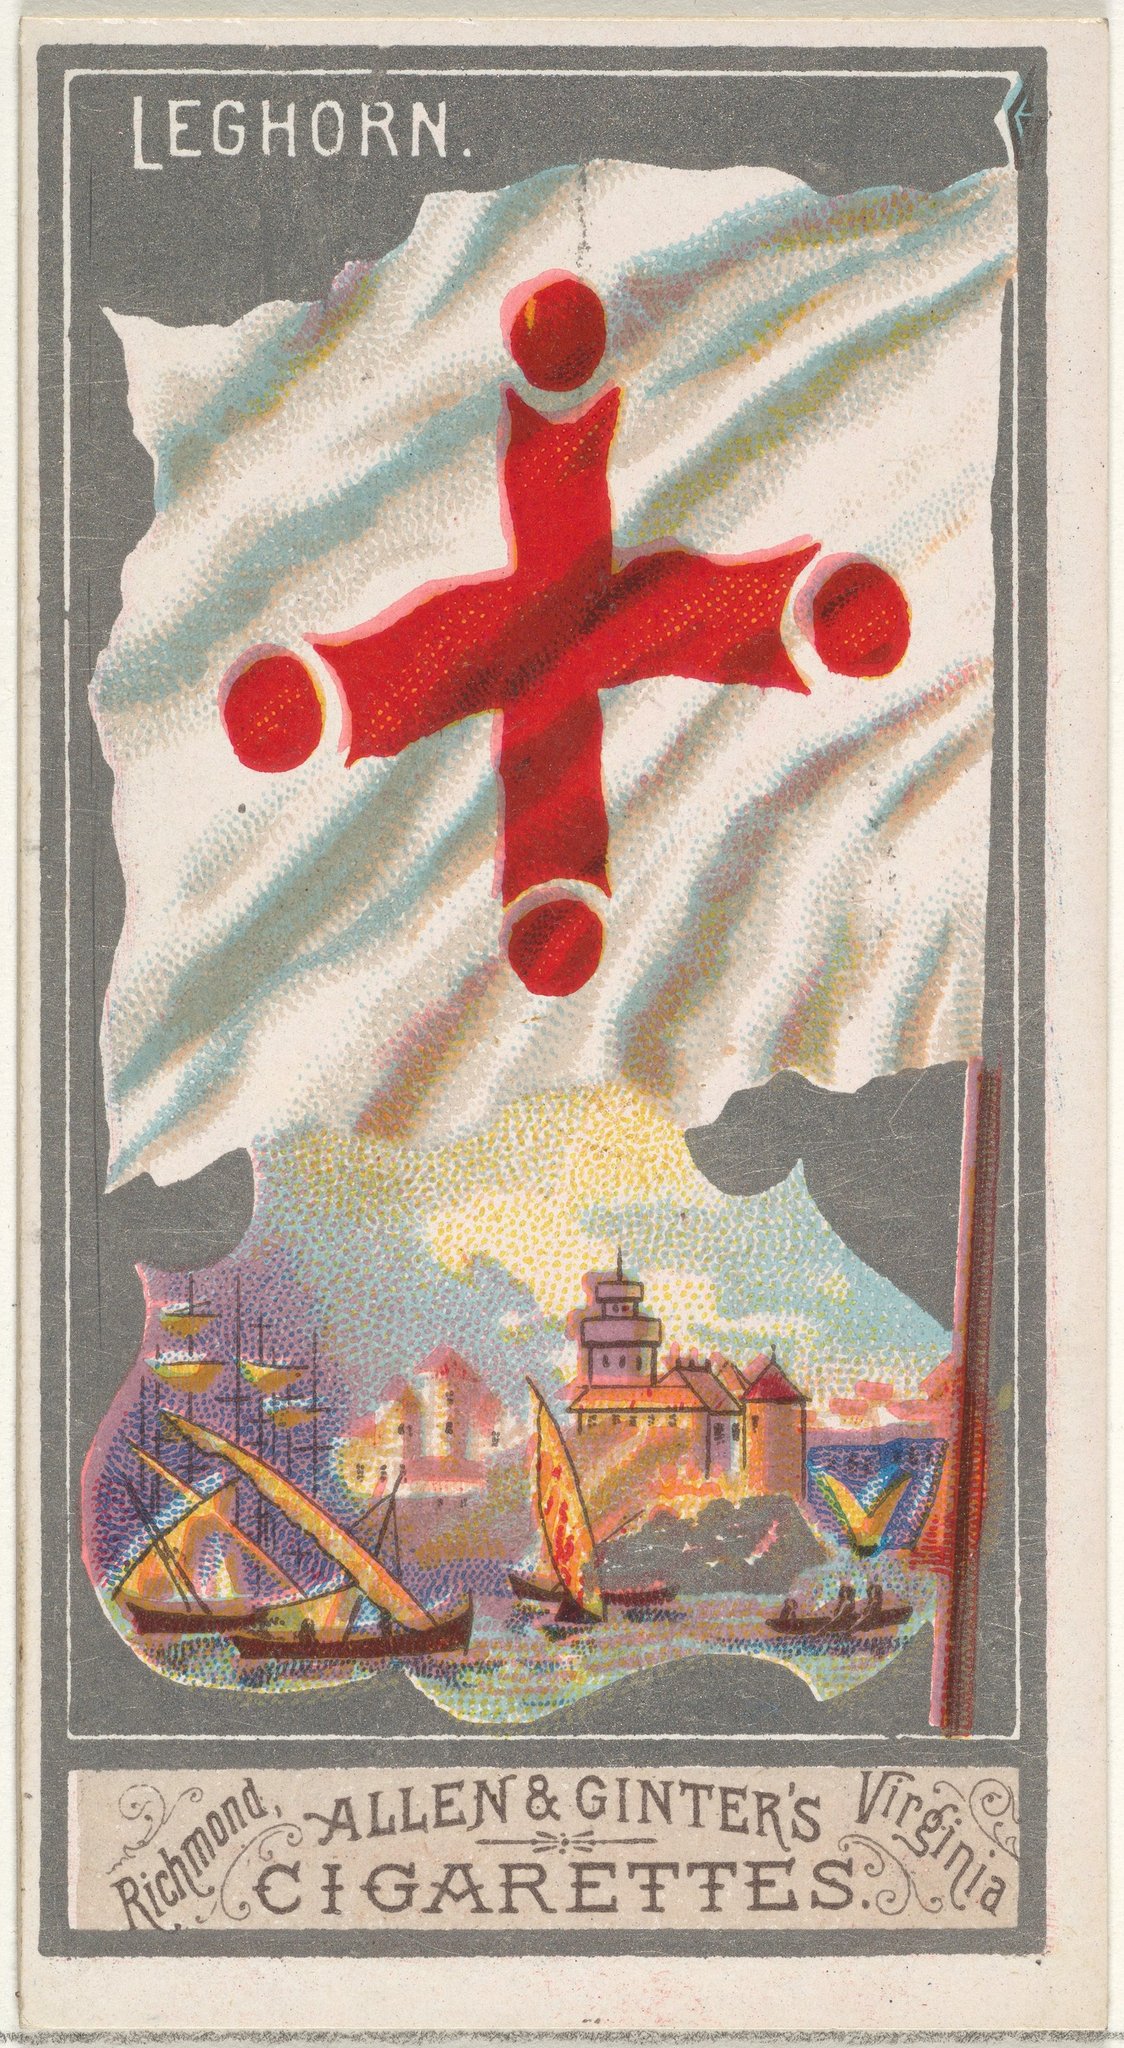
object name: print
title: Leghorn, from the City Flags series (N6) for Allen & Ginter Cigarettes Brands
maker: allen & ginter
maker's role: publisher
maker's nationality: american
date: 1887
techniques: color lithograph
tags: flags